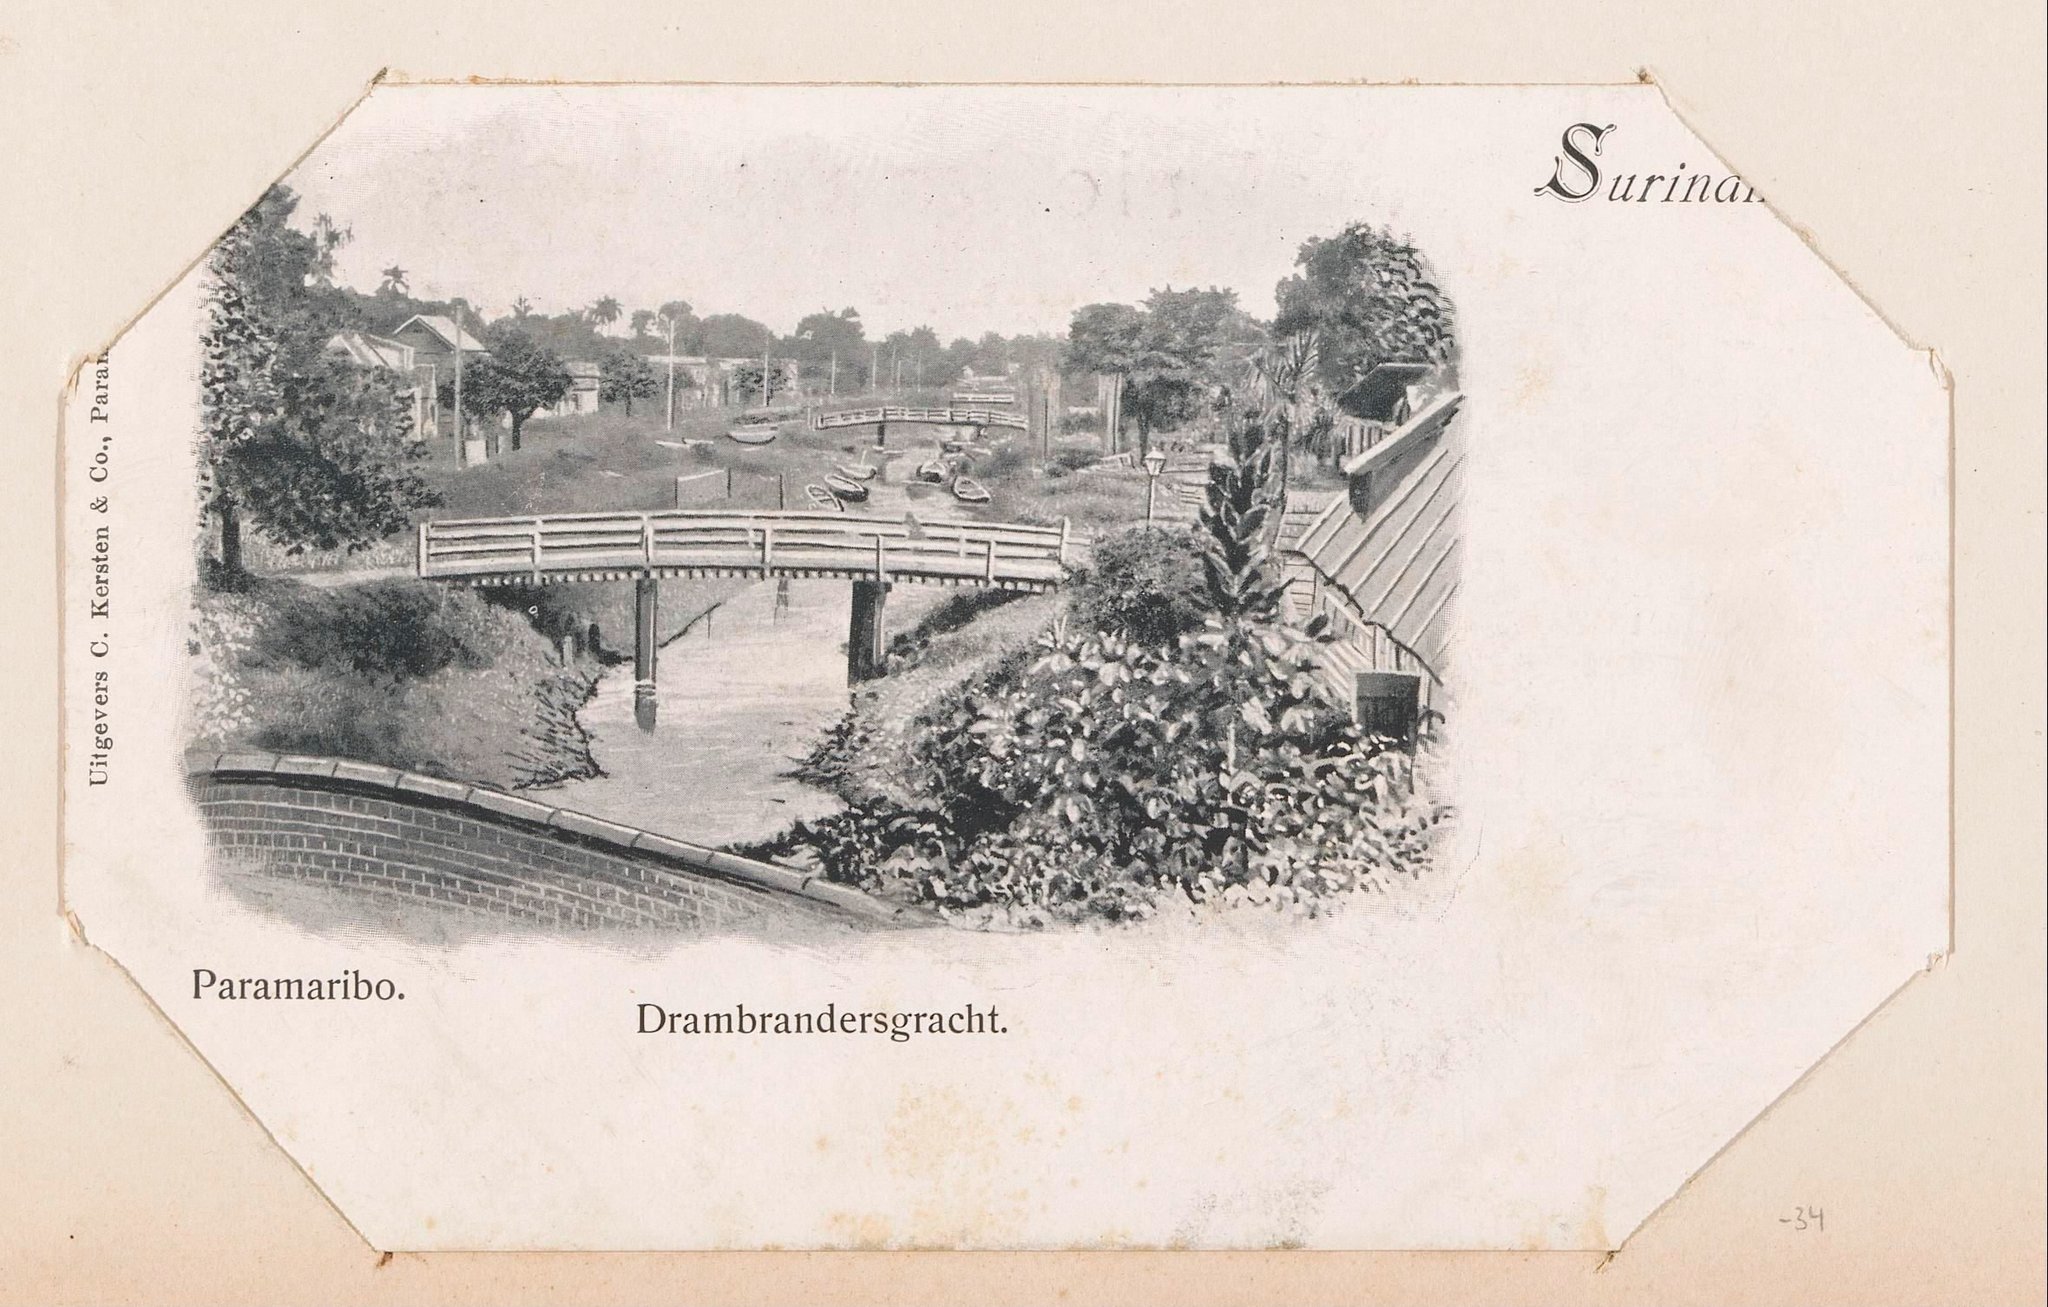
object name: ansichtkaart, prentbriefkaart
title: Drambrandersgracht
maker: Anonymous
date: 1900-1910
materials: cardboard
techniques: autotype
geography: paramaribo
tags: canals, waters (in city), bridge in city across river, canal, etc.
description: Gezicht in de Drambrandersgracht te Paramaribo. Onderdeel van een verzameling van 68 briefkaarten uit Suriname, bijeengebracht in een album als aandenken aan een verblijf in Suriname in september 1911.